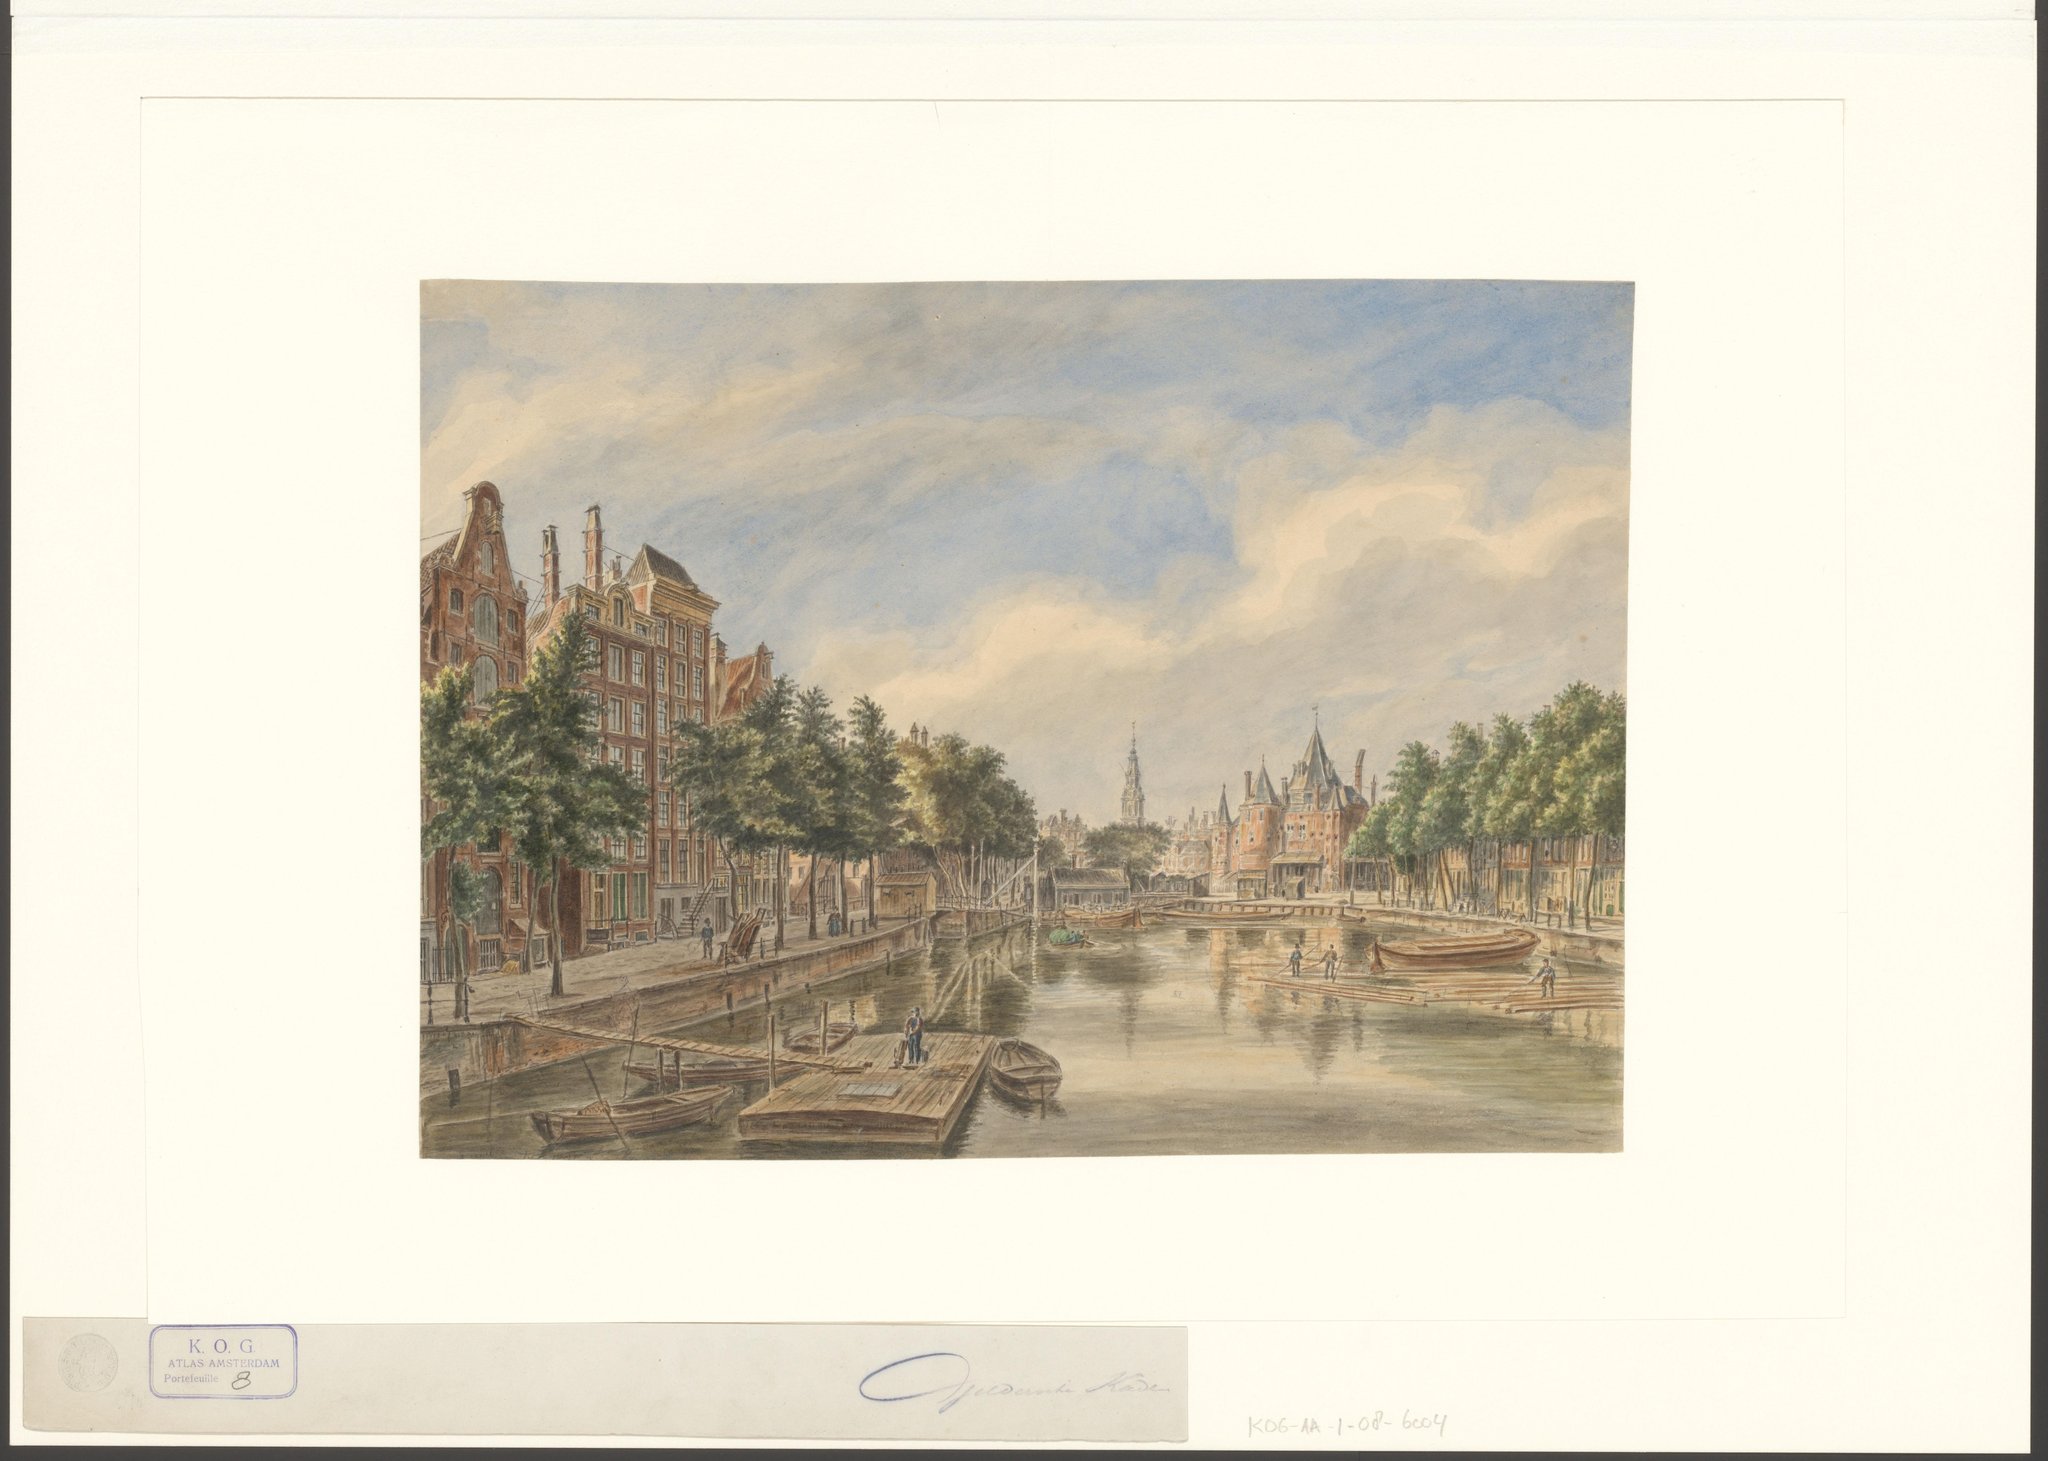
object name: drawing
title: Gezicht op de Geldersekade, gezien naar de Nieuwmarkt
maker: Anonymous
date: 1800-1899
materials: ink, paper, pencil, watercolor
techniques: brush, pen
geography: amsterdam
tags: city-view in general; 'veduta', canal, street, weigh-house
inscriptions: inscription: ‘Geldersekade’, check stamp: ‘Bristol / Board’, inscription: ‘48 / Nieuwmarkt’, collector's mark: ‘8’ Lugt 1641b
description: Onderwerpsrubriek binnen de Atlas Amsterdam: Galerij Paleis voor Volksvlijt, Gebed zonder end, Geldersche Kade, Gravenstraat, Grimburgwal, Grimnessesluis, Groeneburgwal.